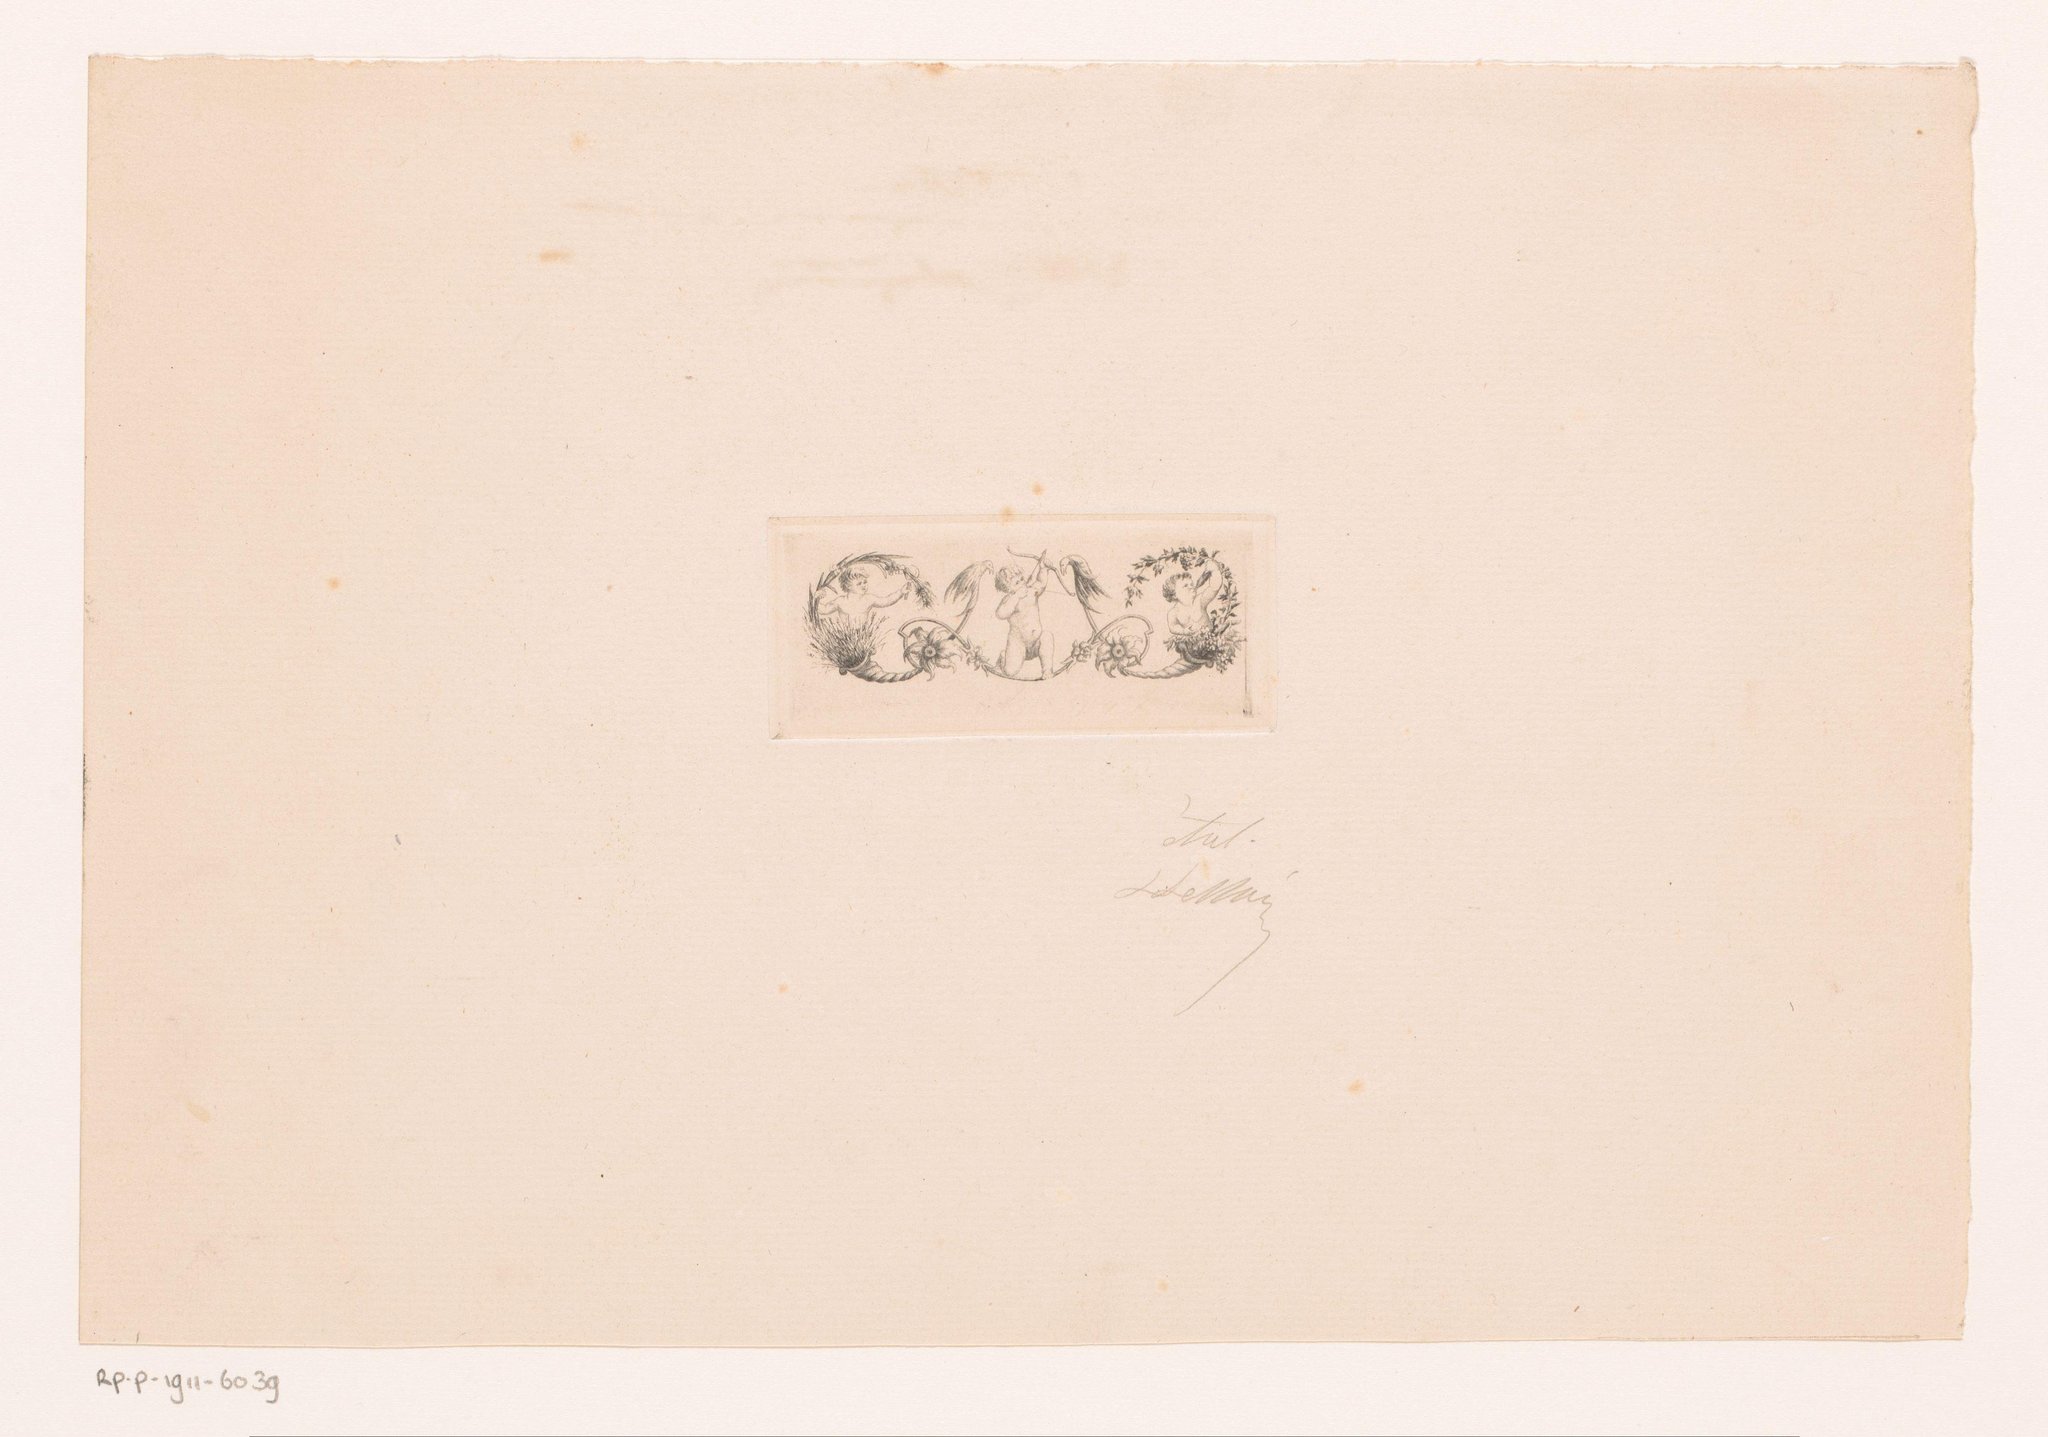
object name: print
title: Putto met pijl en boog met aan weerszijden ornamentele ranken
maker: louis le nain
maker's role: print maker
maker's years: 1851-1939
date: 1861-1911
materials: paper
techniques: etching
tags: 'cornucopia', horn of plenty, attributes of cupid: bow and arrow, cupids: 'amores', 'amoretti', 'putti'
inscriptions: inscription: ‘Etat LLe Nain’, collector's mark: Lugt 2228